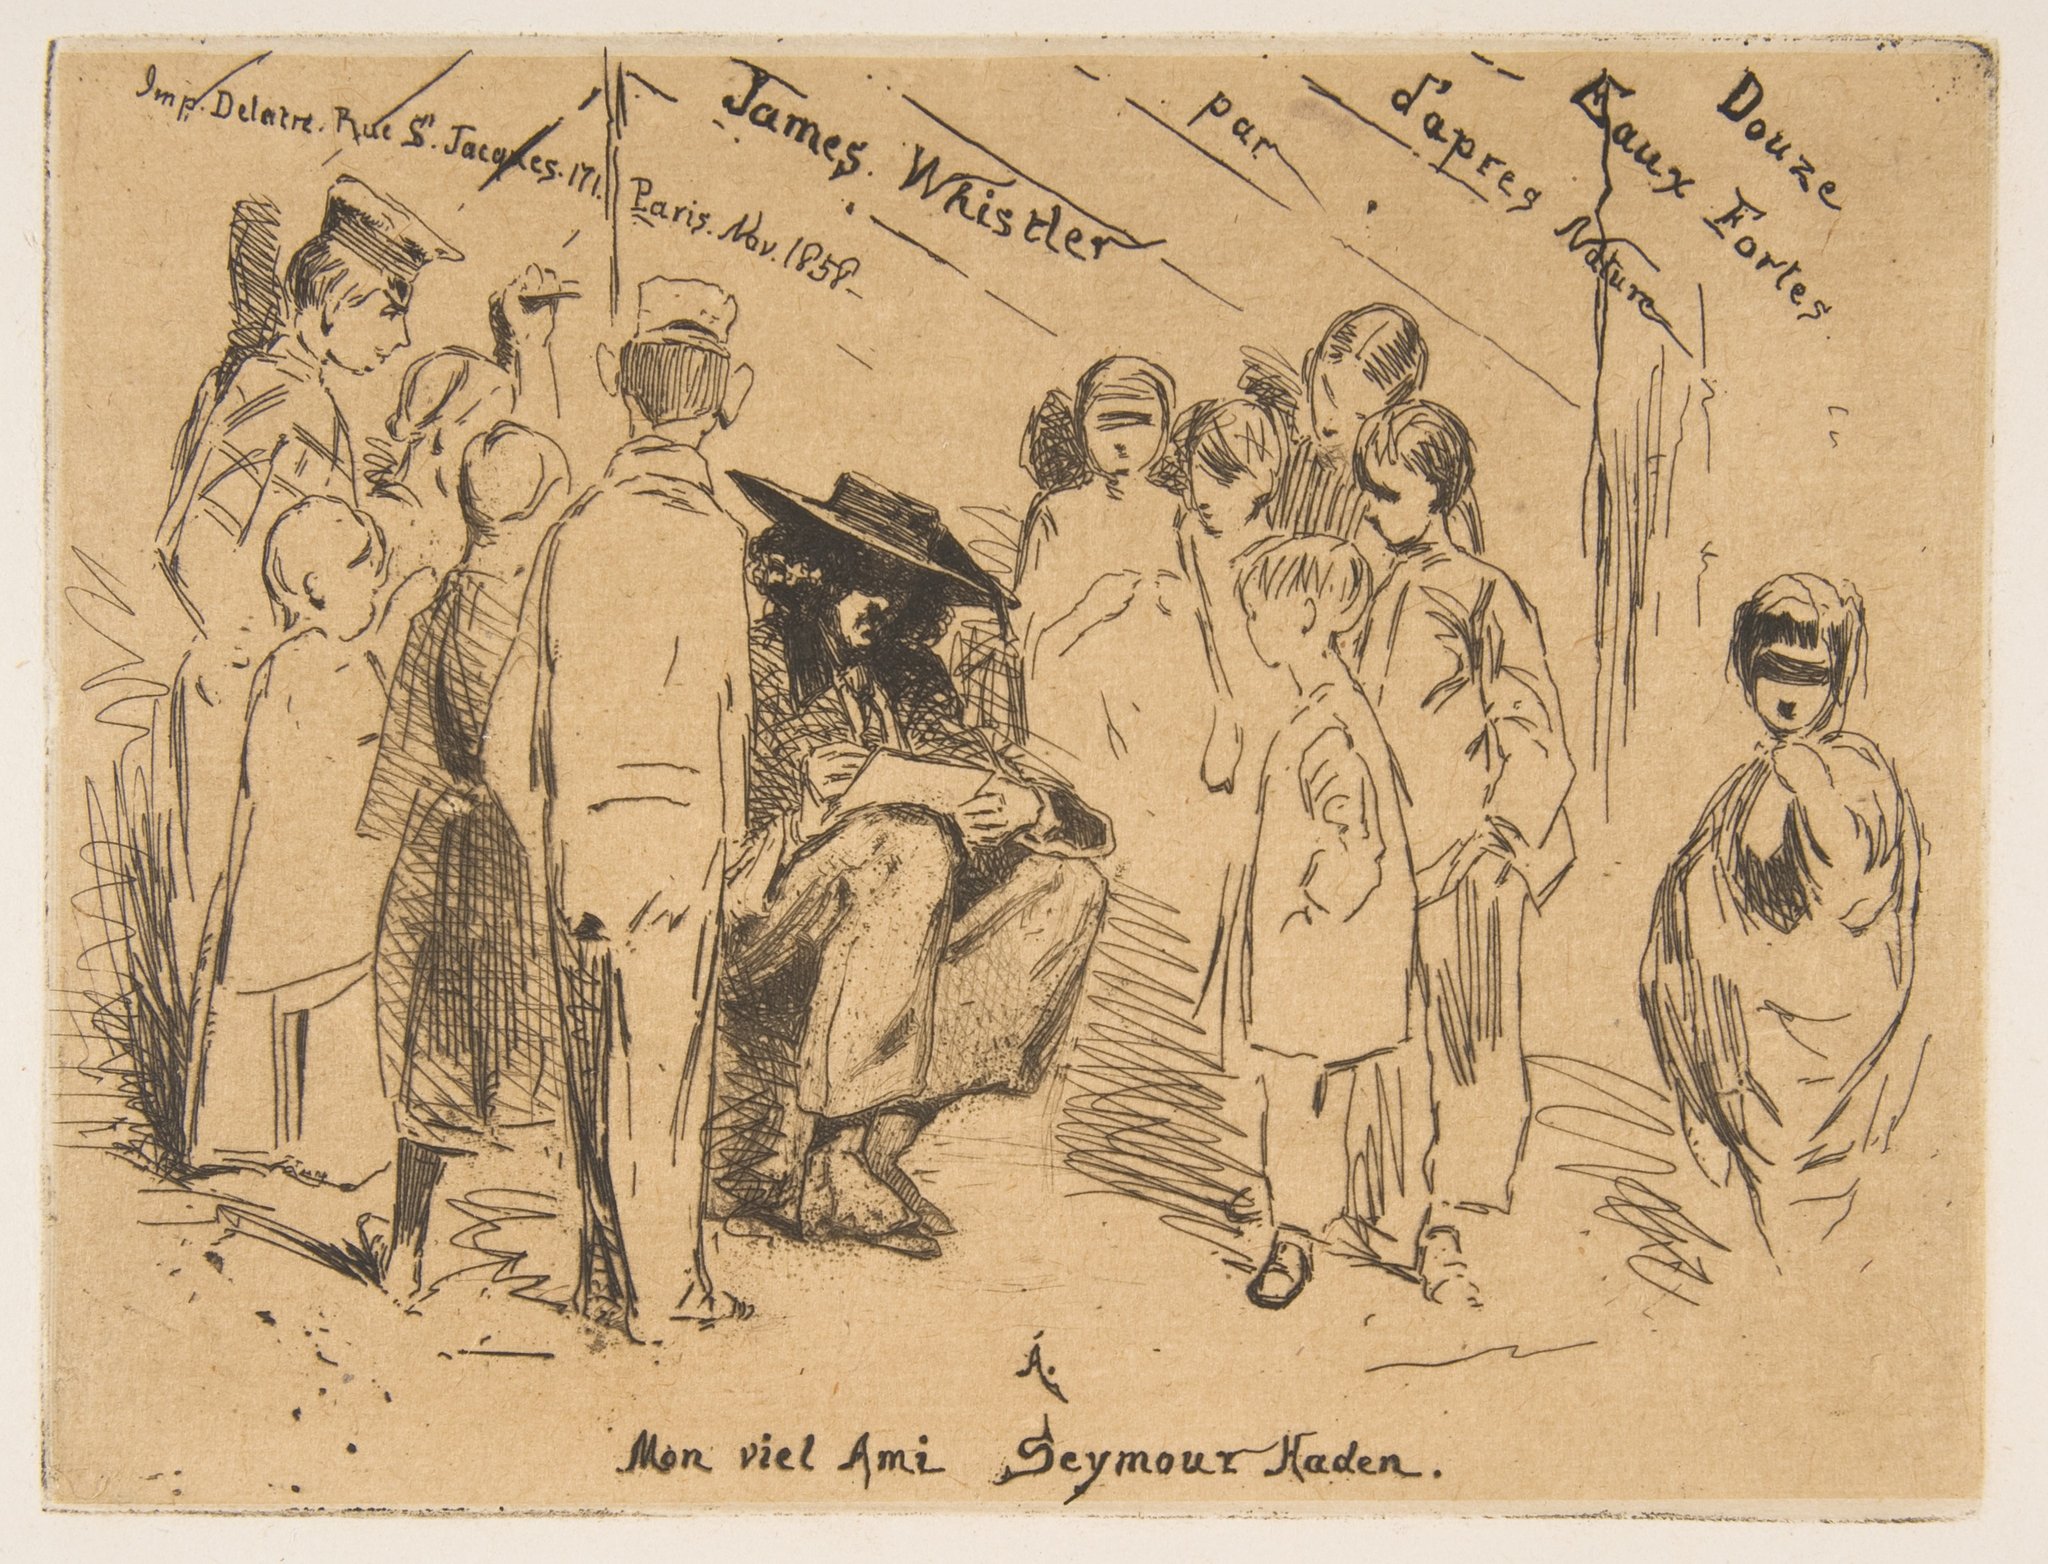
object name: print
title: The Title to the French Set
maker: james mcneill whistler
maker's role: artist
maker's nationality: american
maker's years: 1834-1903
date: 1858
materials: chine, ink, paper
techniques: printmaking, etching, printing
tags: children,men